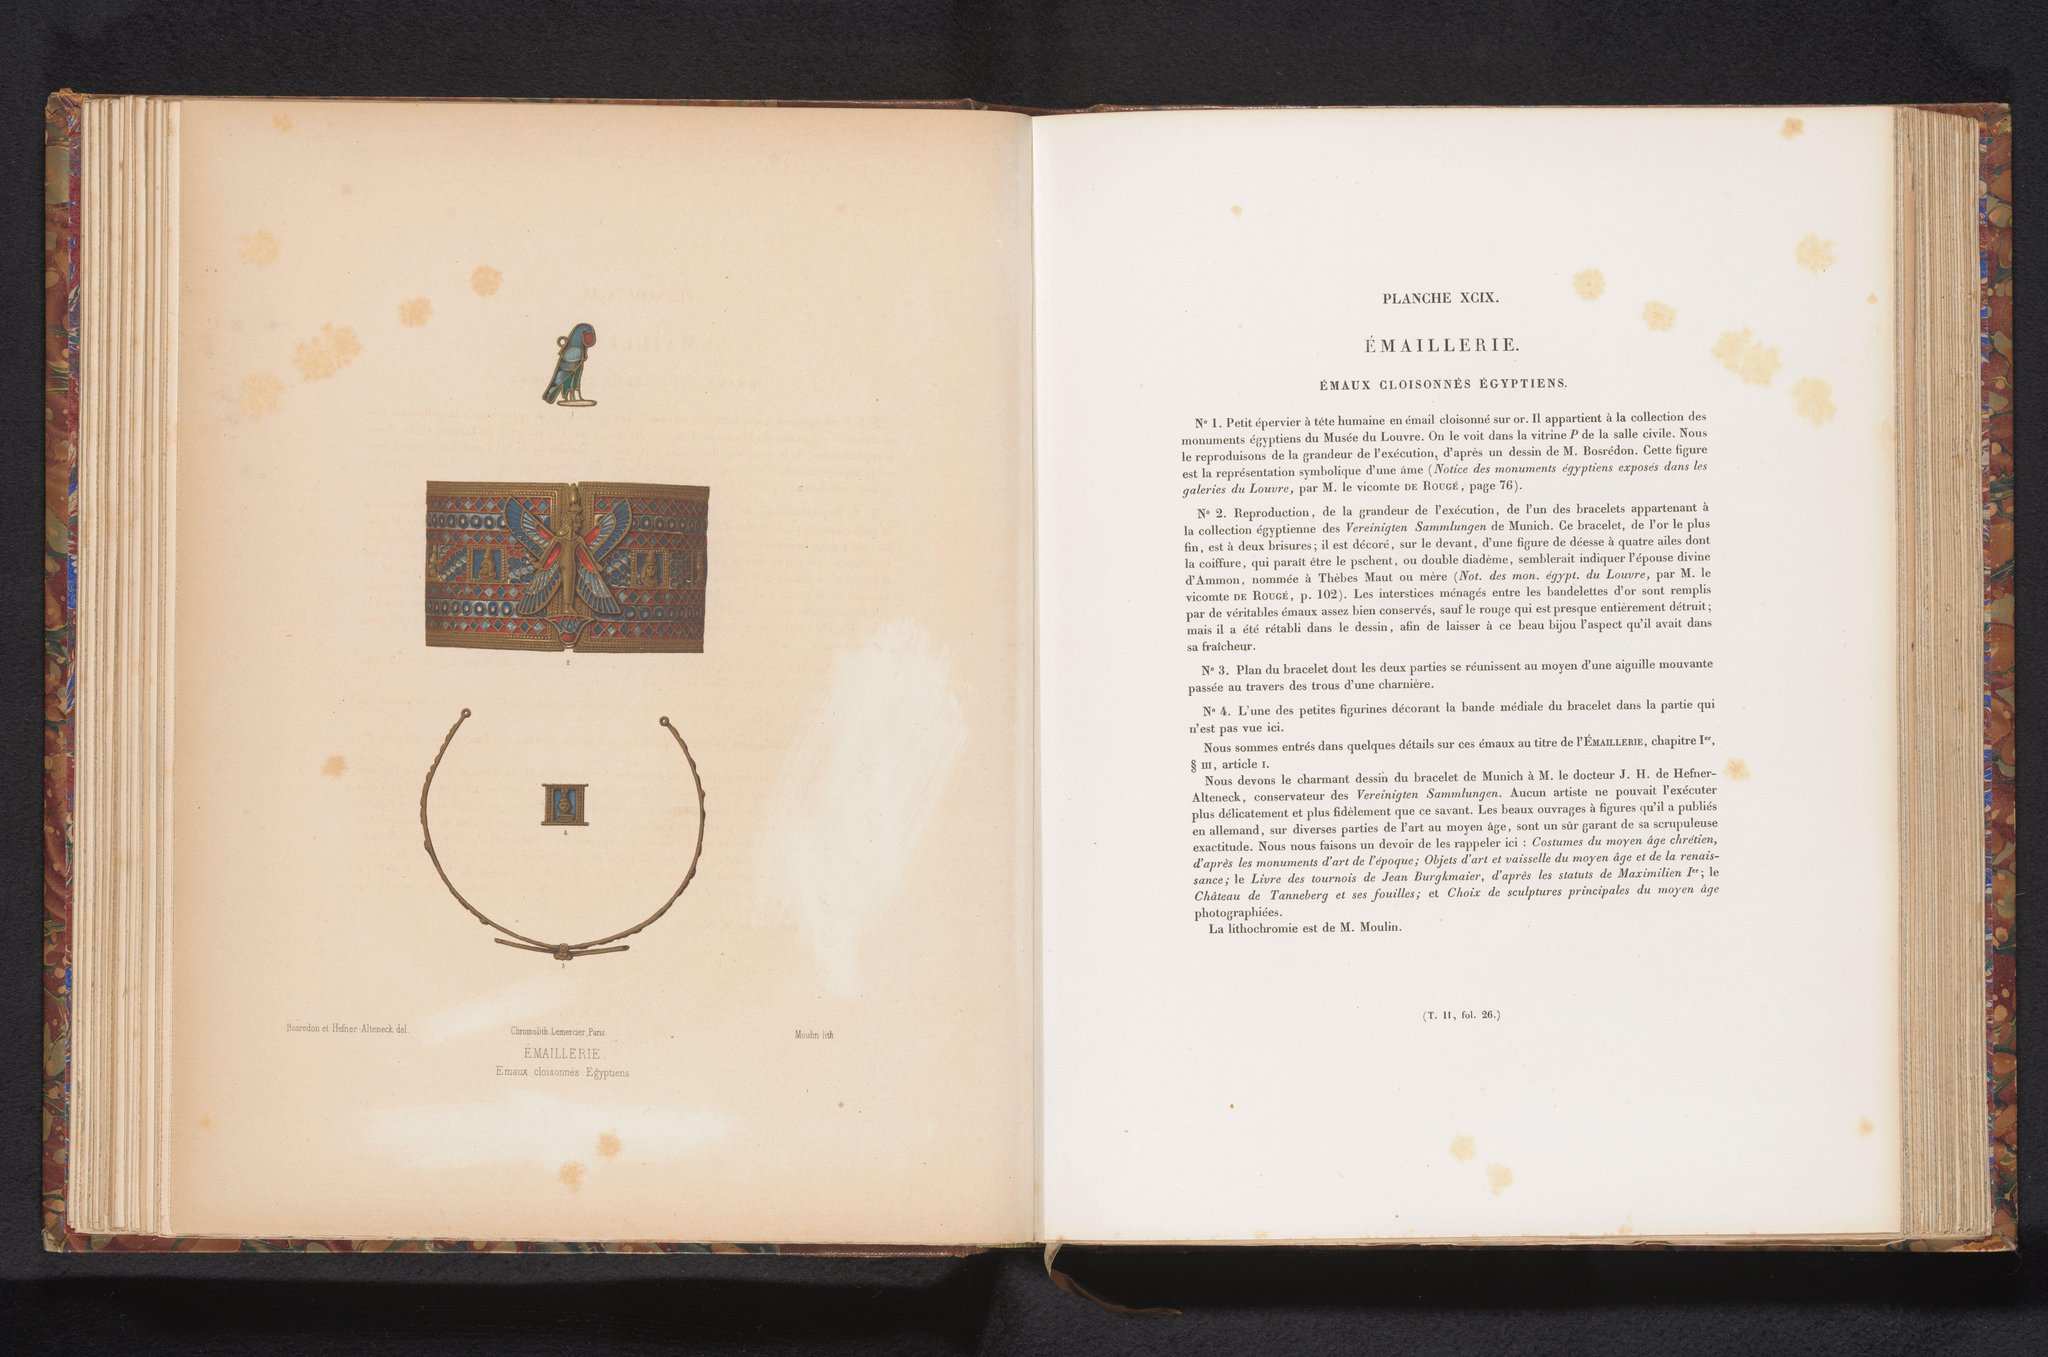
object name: print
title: Reproductie van een ontwerp met vier sieraden uit Egypte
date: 1859-1864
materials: paper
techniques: chromolithography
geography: paris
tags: ornaments, jewels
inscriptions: name: ‘Bosredon et Hefner-Alteneck del./ Moulin lith.’